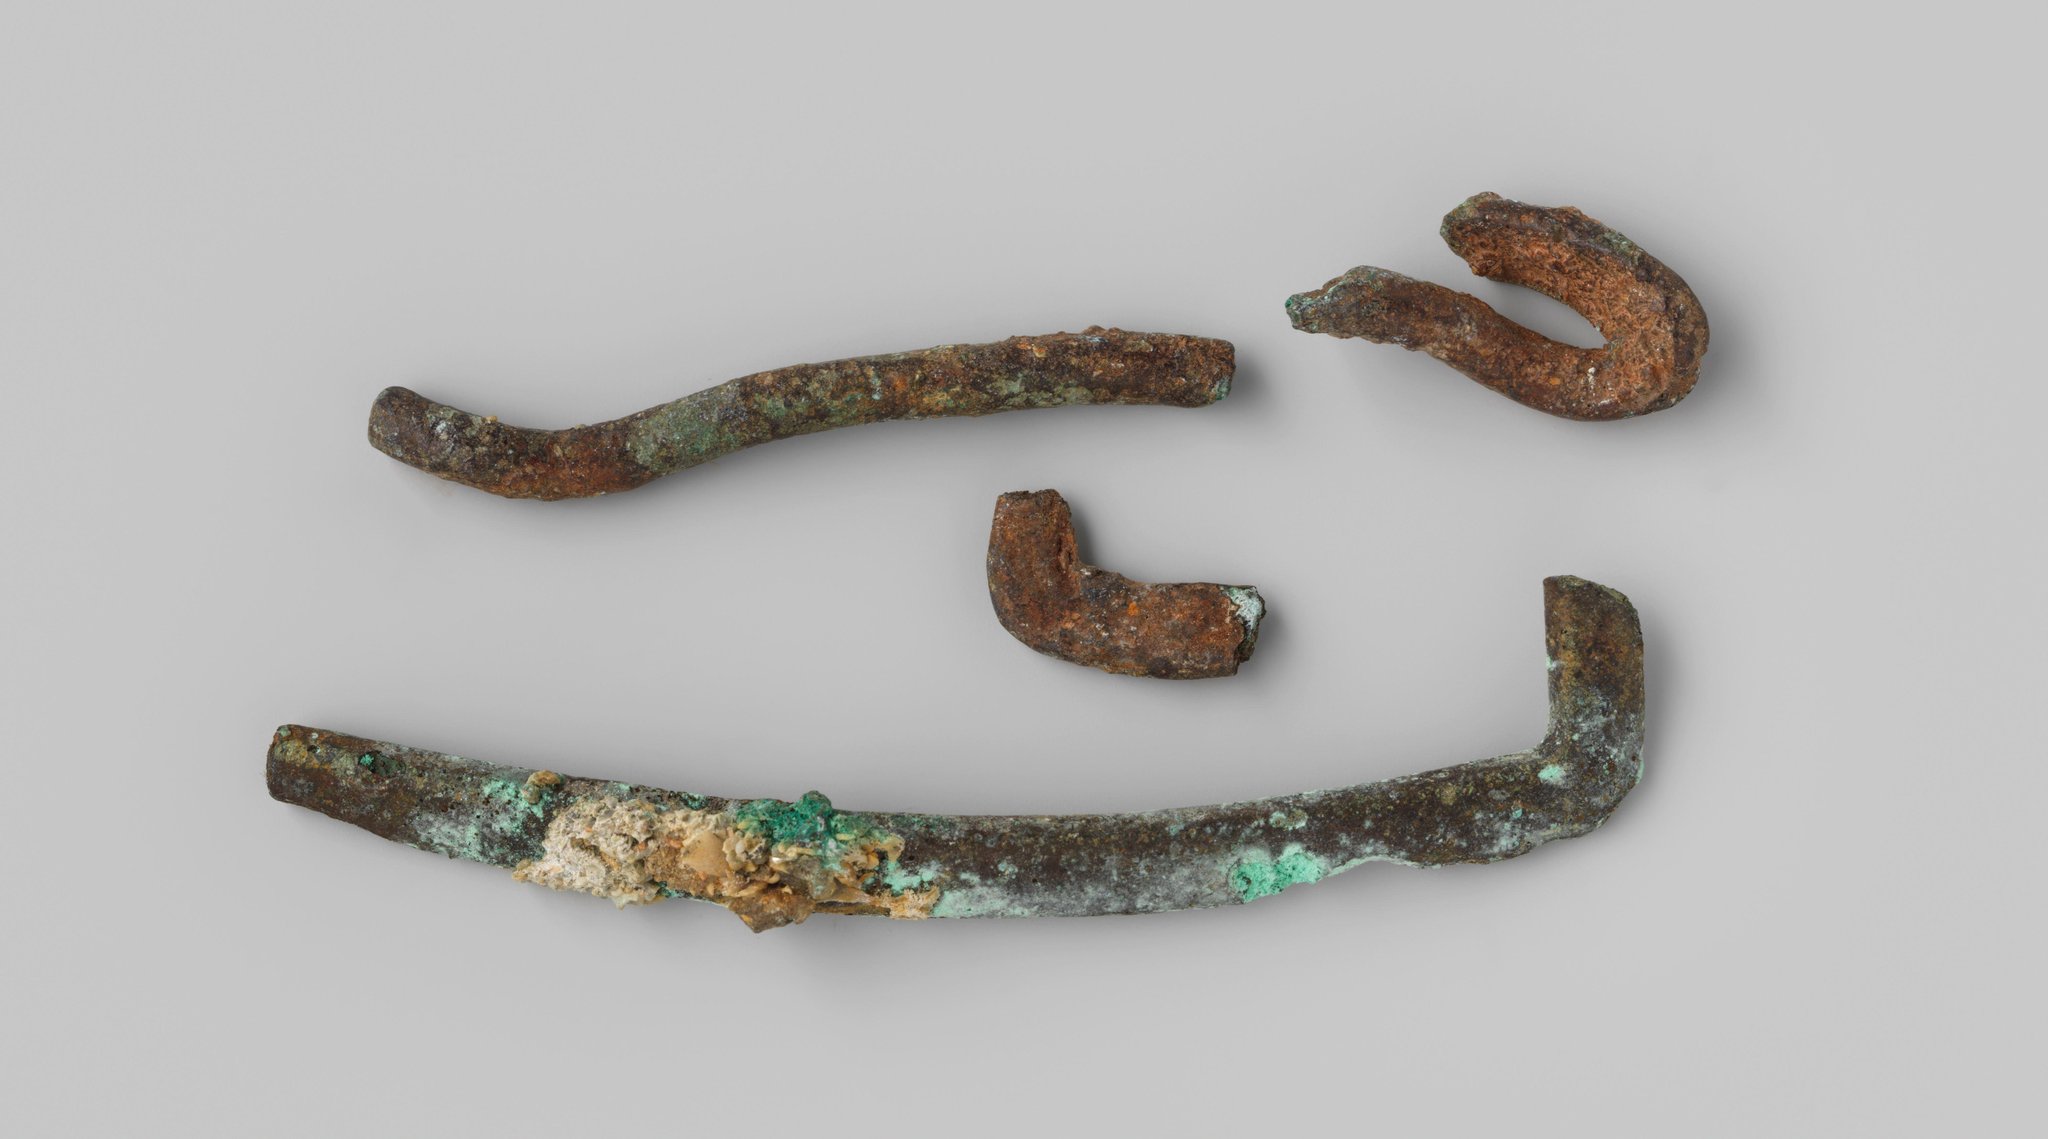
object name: belt buckle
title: Fragmenten riemgesp uit het wrak van de Oost-Indiëvaarder Hollandia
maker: Anonymous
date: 1700-1743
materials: copper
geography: netherlands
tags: verenigde oostindische compagnie, hollandia (schip), annet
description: Rectangular, fragm of ring with spindle, id. NG 1980-27H2852, belt buckle.